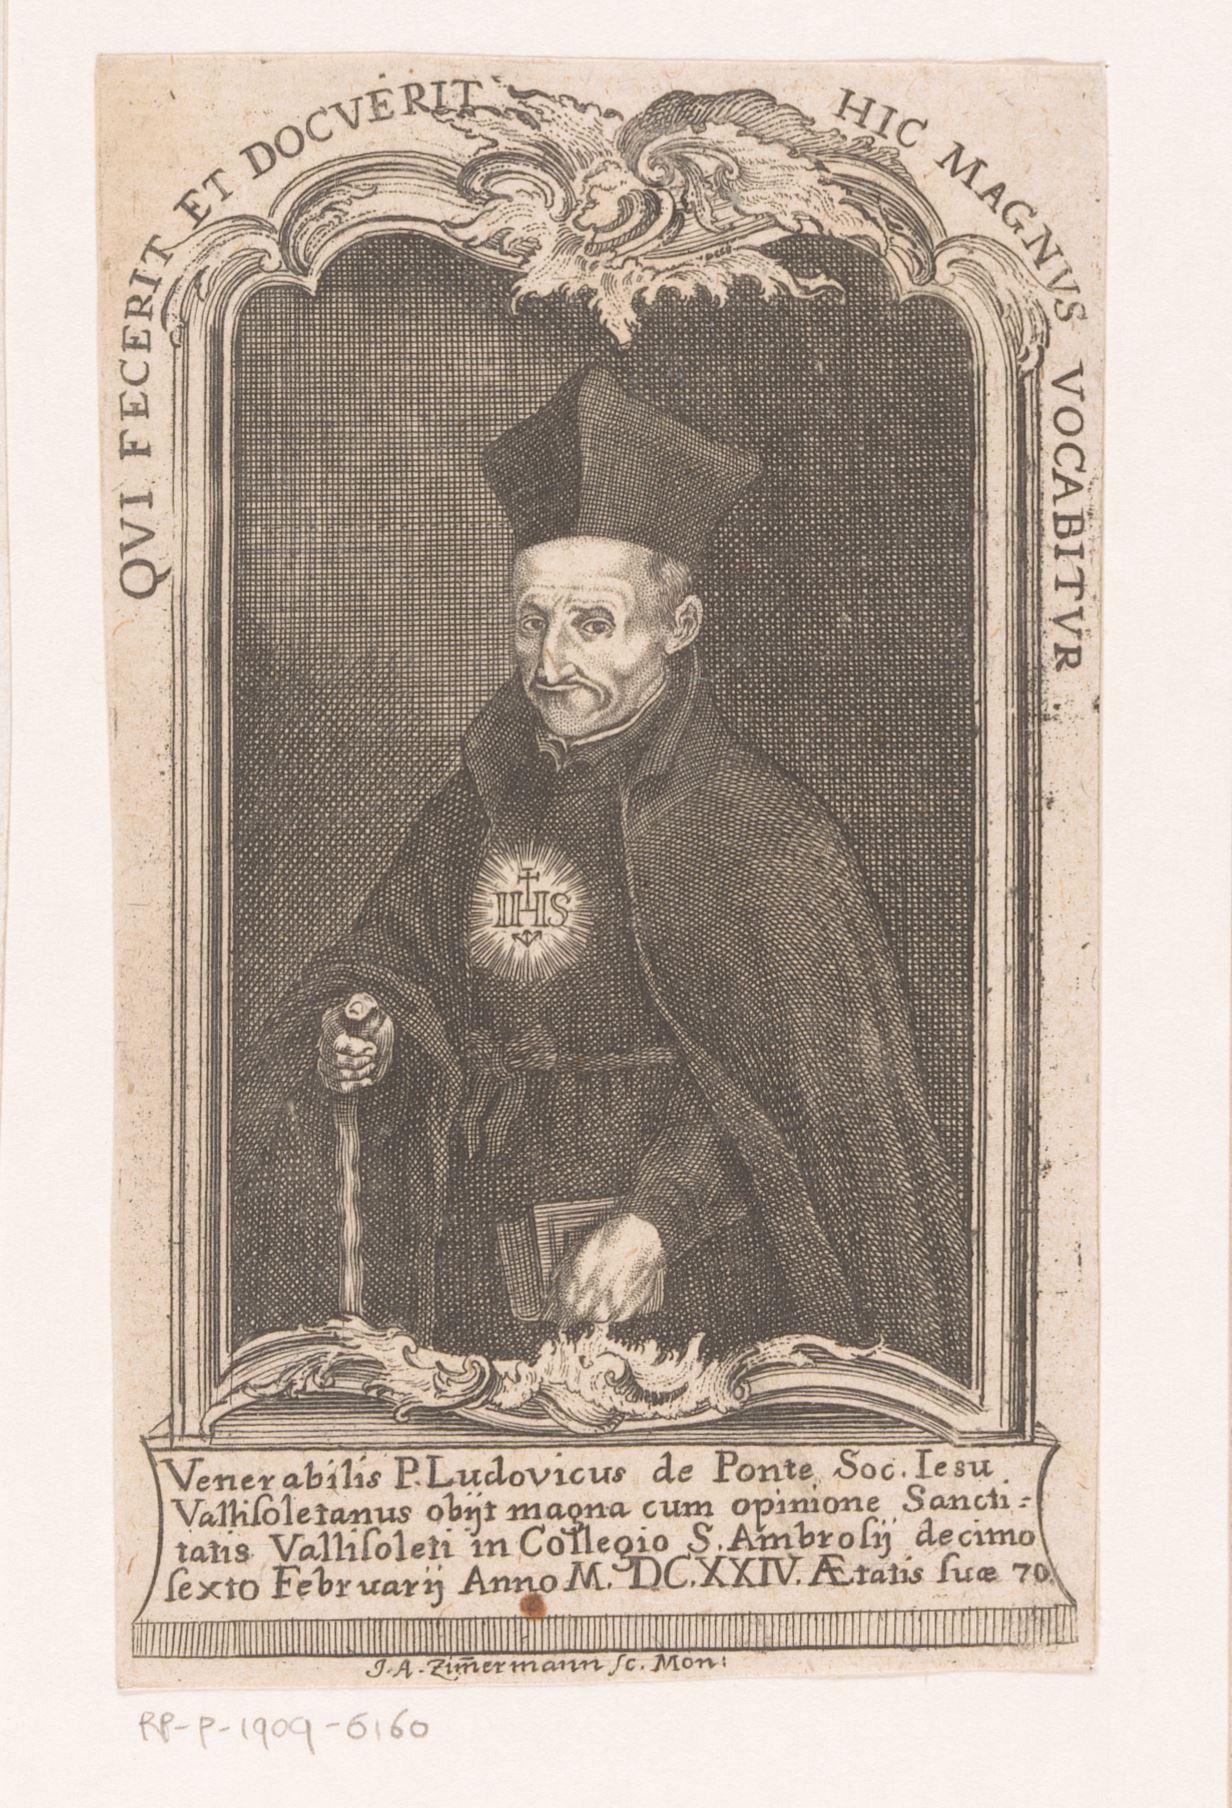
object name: print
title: Portret van Luis de la Puente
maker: joseph anton zimmermann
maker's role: draughtsman, print maker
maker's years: 1705-1797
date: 1715-1797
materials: paper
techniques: engraving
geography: munich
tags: historical persons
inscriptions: collector's mark: Lugt 2228